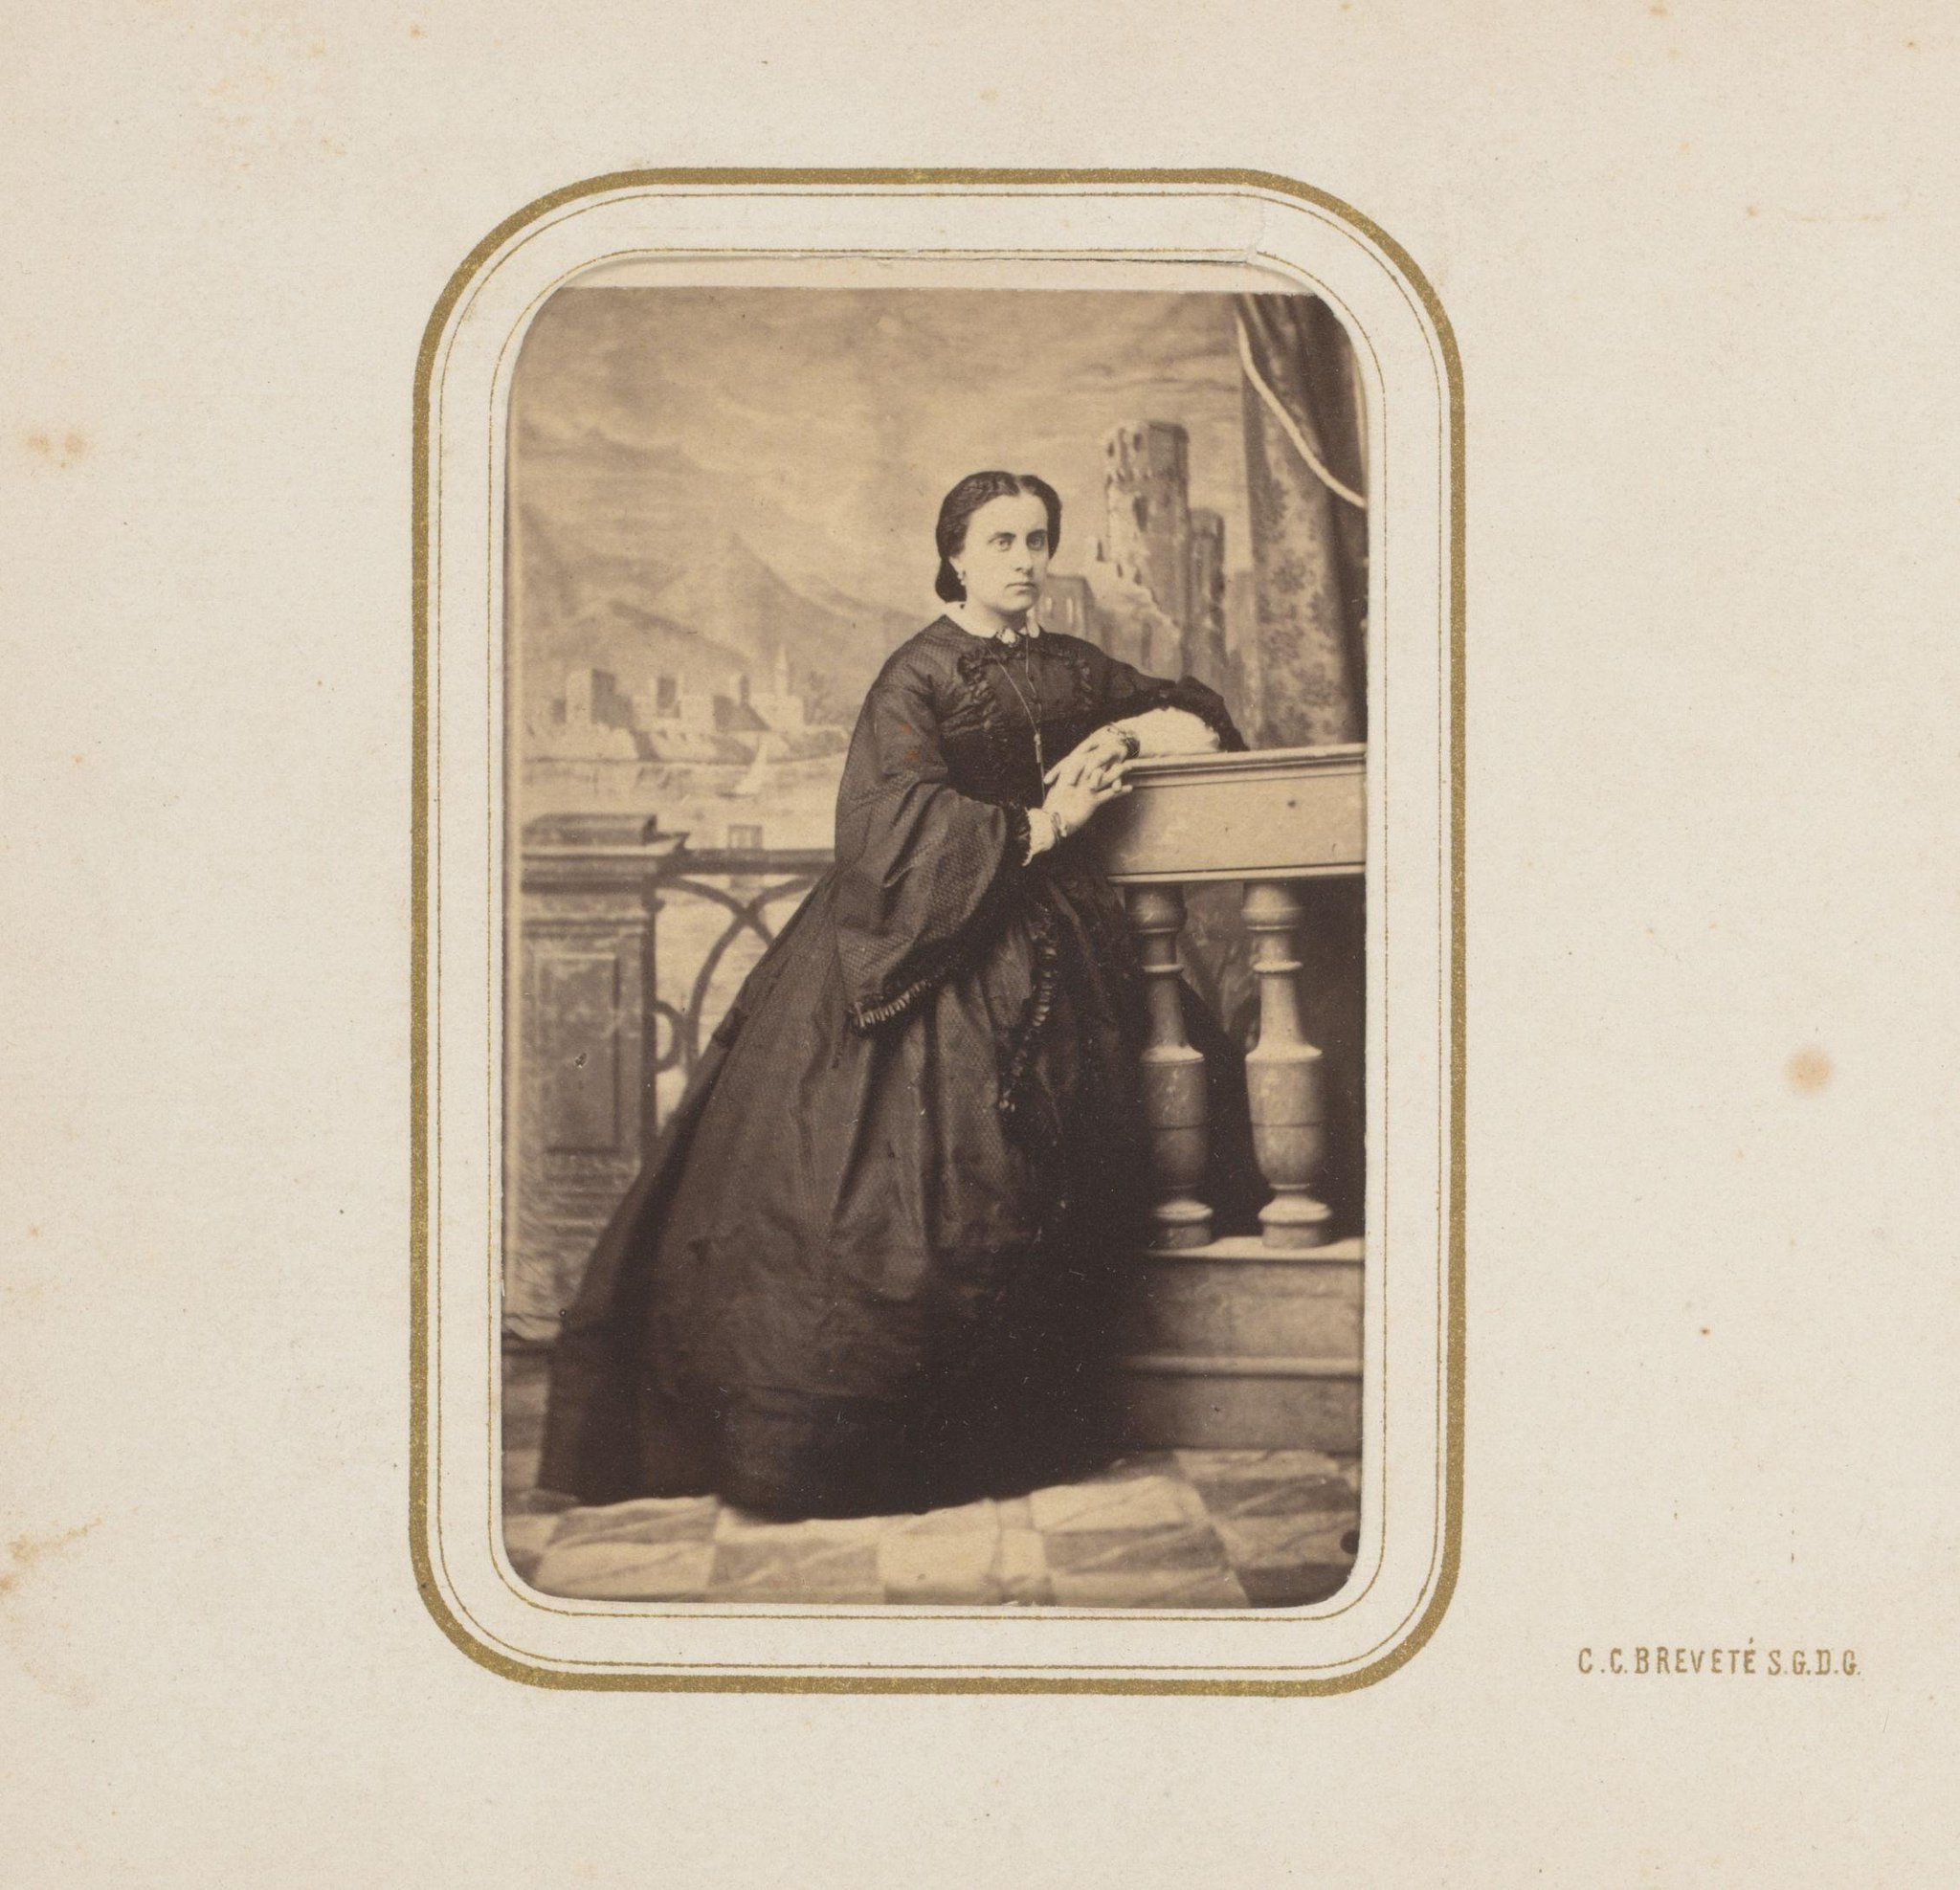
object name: album leaf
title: Portret van een vrouw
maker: conde de lipa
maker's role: fotograaf, kapitein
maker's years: 1793-1871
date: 1860-1900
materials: cardboard, photographic support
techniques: albumen print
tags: historical persons, standing figure - aa - female human figure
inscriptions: inscription: ‘L. C. de Lipa/ Fotografo/ de. S.S.M.M.yA.A.’